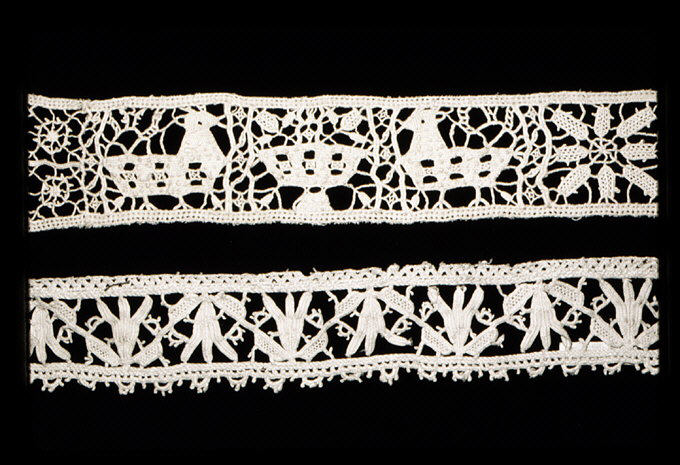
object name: strip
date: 1501-1700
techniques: lace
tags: animals